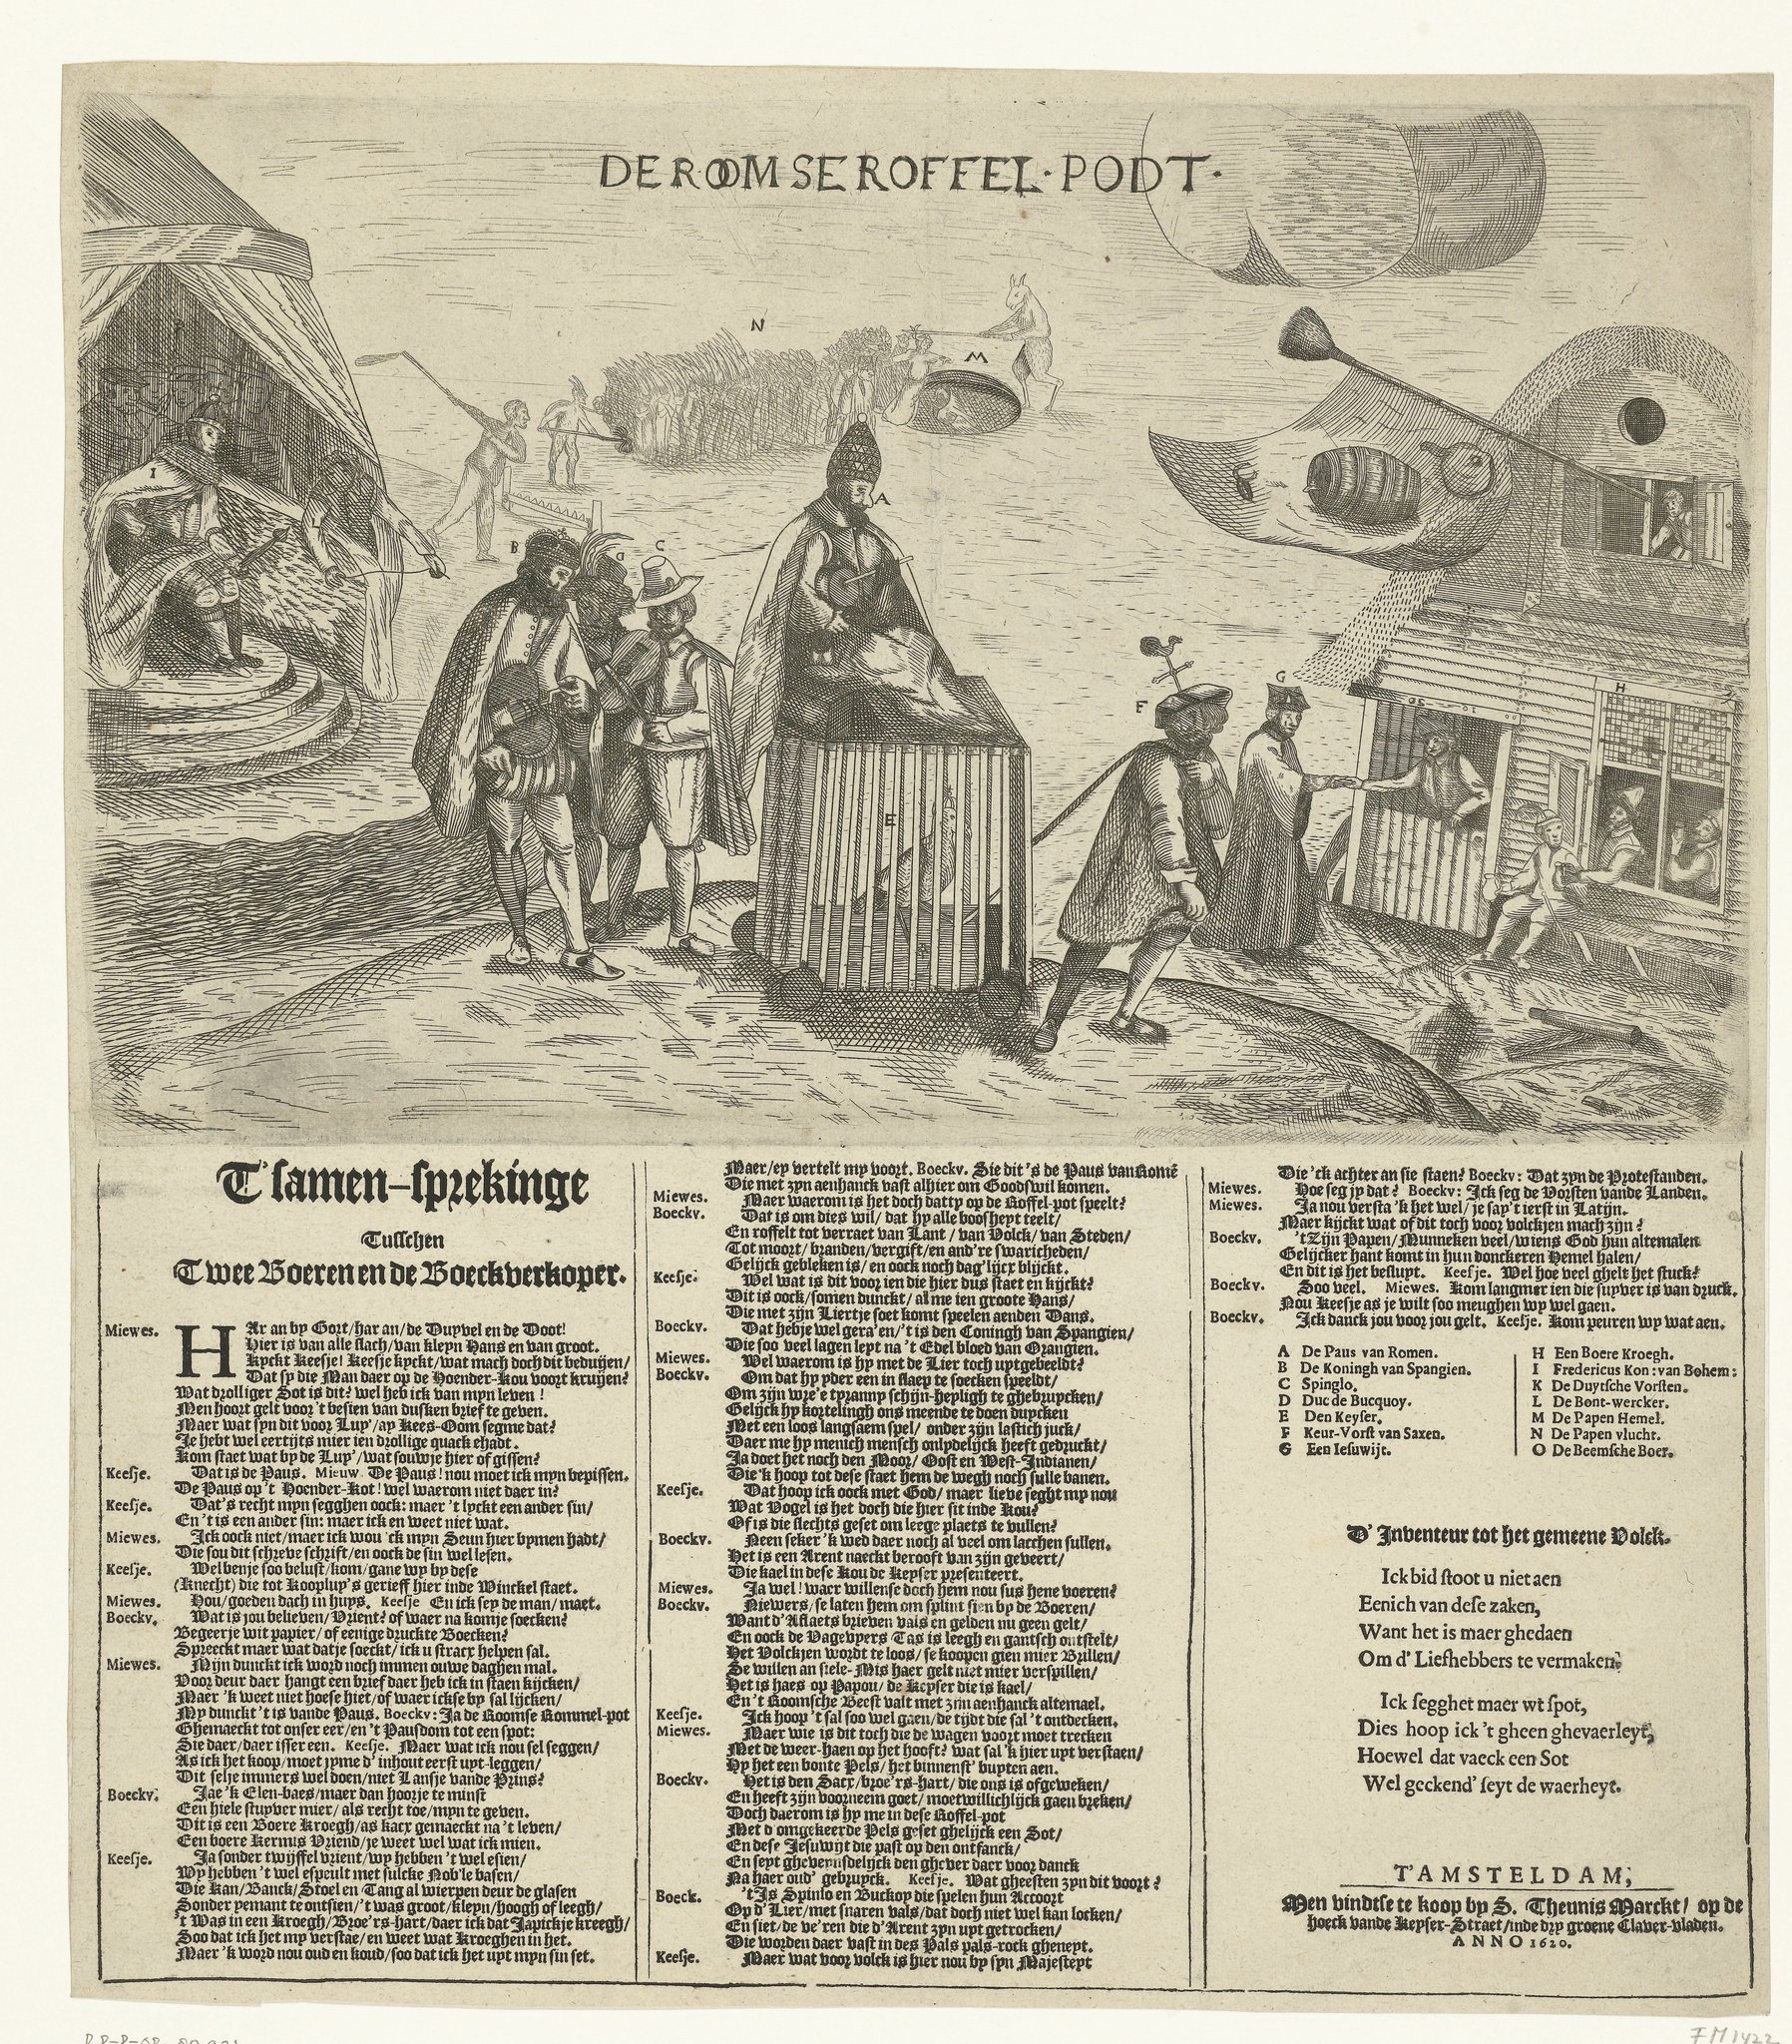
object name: print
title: De Roomse Roffel-Podt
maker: Anonymous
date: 1620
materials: paper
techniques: etching, letterpress printing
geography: low countries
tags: vienna, ferdinand ii (duits keizer), frederik v (keurvorst van de palts, koning van bohemen), other percussion instruments, bird in a cage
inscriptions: date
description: De Roomse roffelpot. Spotprent op de verliezen van de paus en de Duitse keizer Ferdinand II en op de voordelen van Frederik, koning van Bohemen. De keurvorst van Saksen trekt een kar met een kooi met de kaalgeplukte adelaar, bovenop zit de paus met een rommelpot. Hierbij een groepje muzikanten met de keizer, een jezuïet en Spinola. Links krijgt Frederik de veren aan zijn mantel genaaid, rechts een herberg met bezoekers die de taferelen bespreken. Onder de voorstelling een samenspreking tussen twee boeren en een boekverkoper en de legenda A-O in 3 kolommen in het Nederlands.